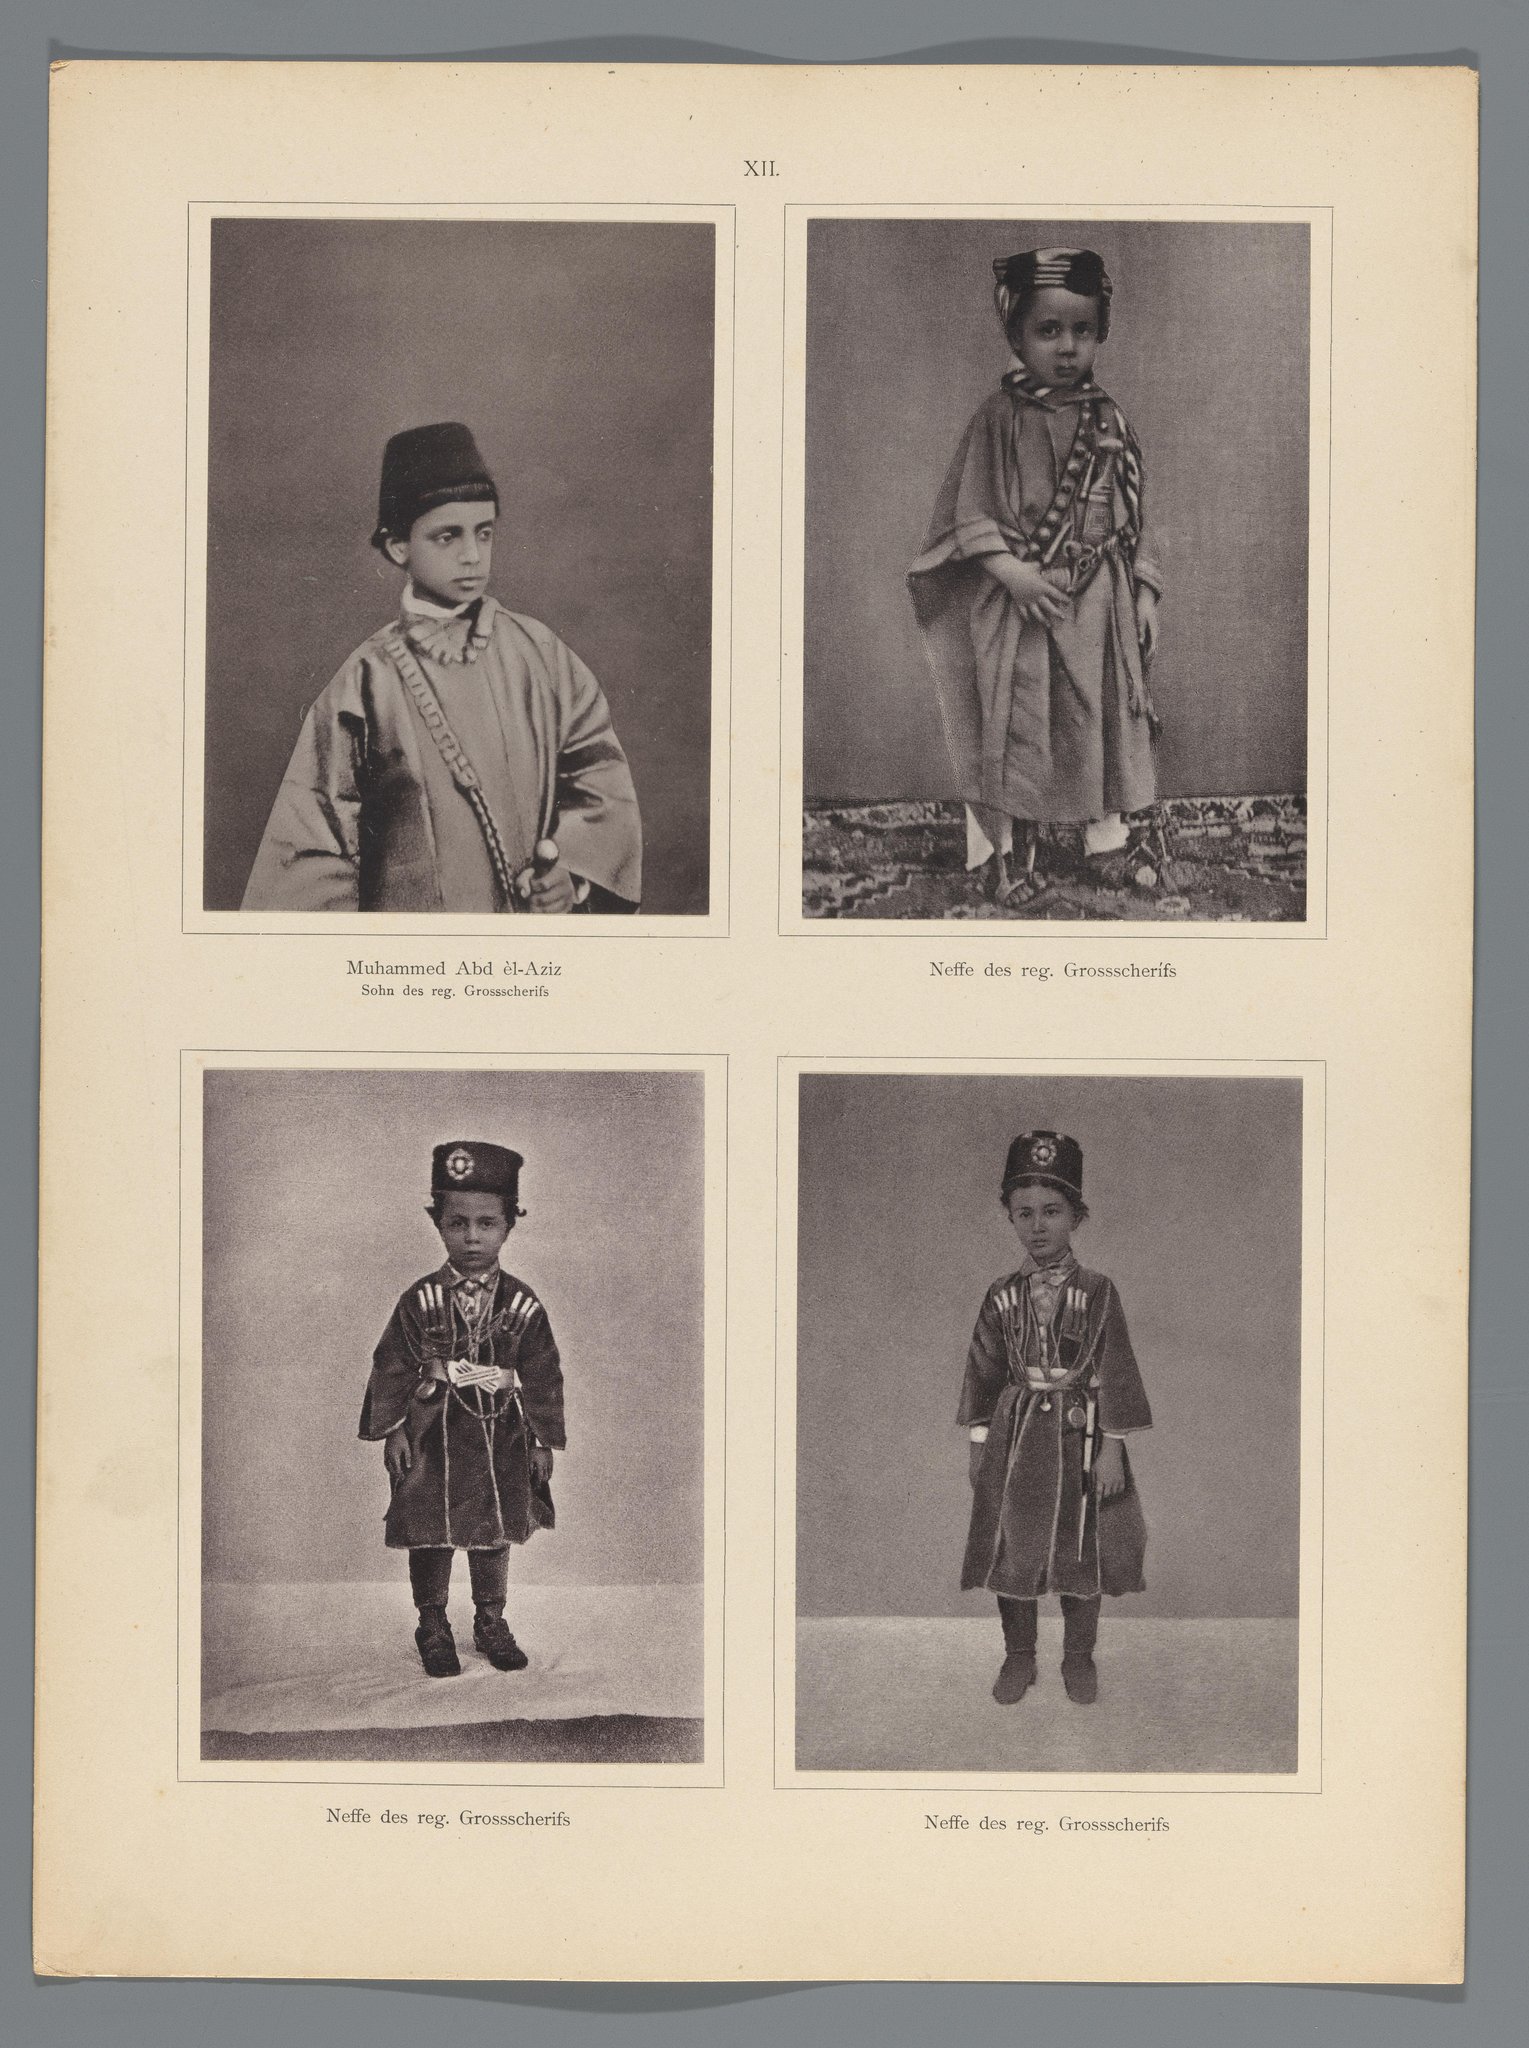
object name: photomechanical print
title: Vier portretten van Muhammed Abd-èl-Aziz en drie neven van de groot-sherif van Mekka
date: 1885-1888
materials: paper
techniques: photograph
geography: mecca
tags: historical persons (portraits and scenes from the life), historical persons not known by name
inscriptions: number: ‘XII.’